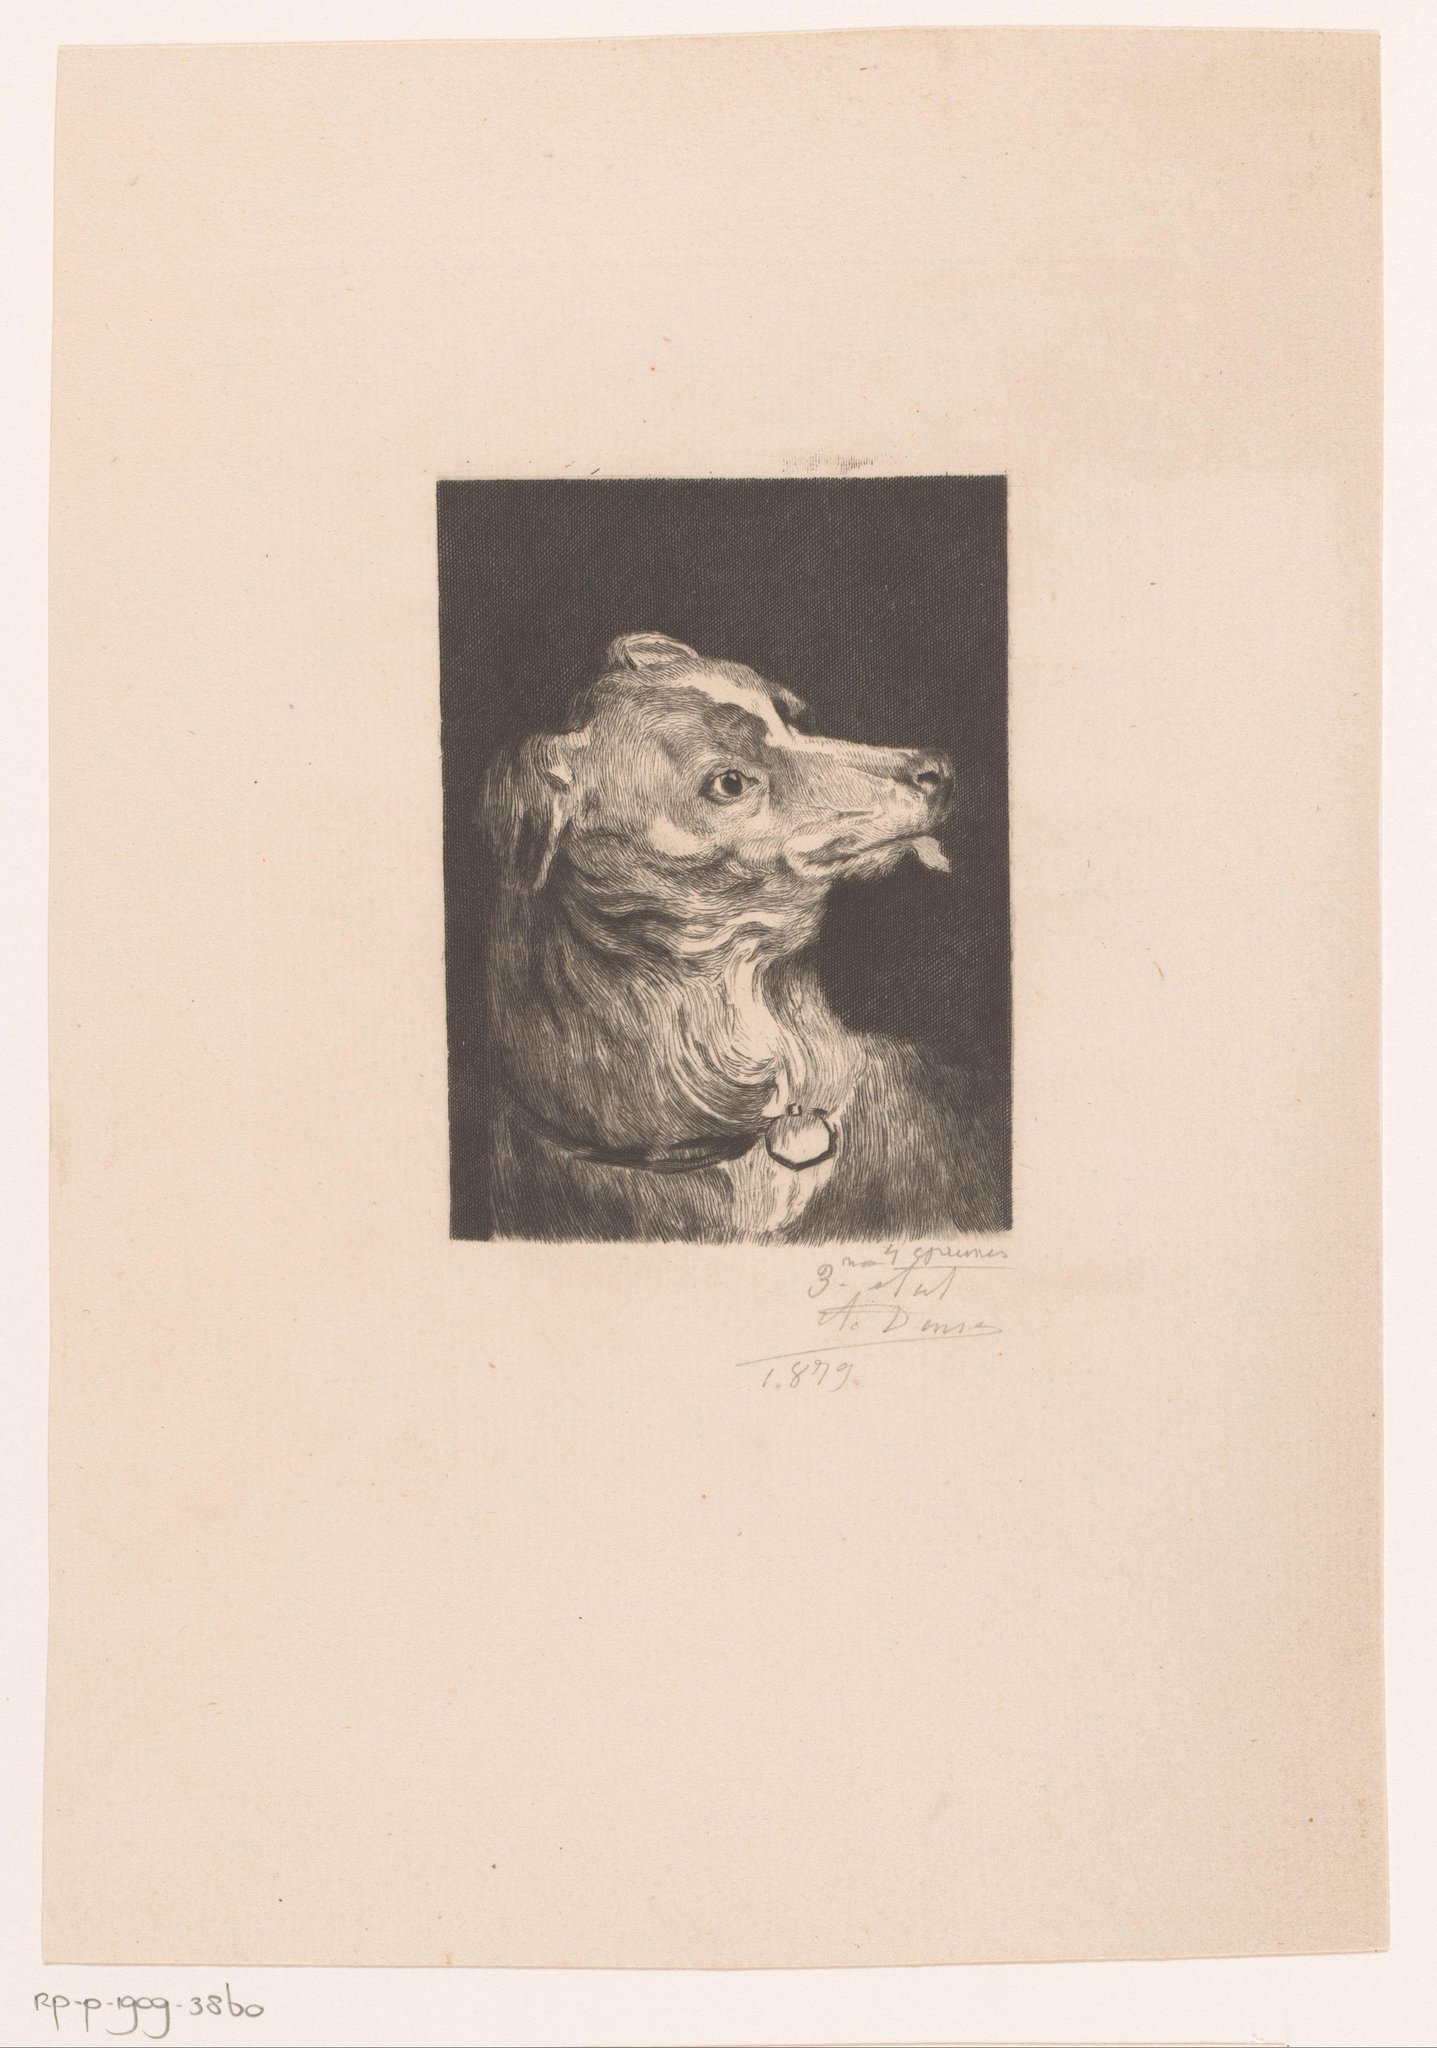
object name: print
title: Kop van een hond met de tong uit de bek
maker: auguste danse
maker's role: print maker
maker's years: 1829-1929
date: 1879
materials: paper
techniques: etching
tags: dog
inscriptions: collector's mark: Lugt 2228, annotation: ‘3me etat; 4 epreuves’